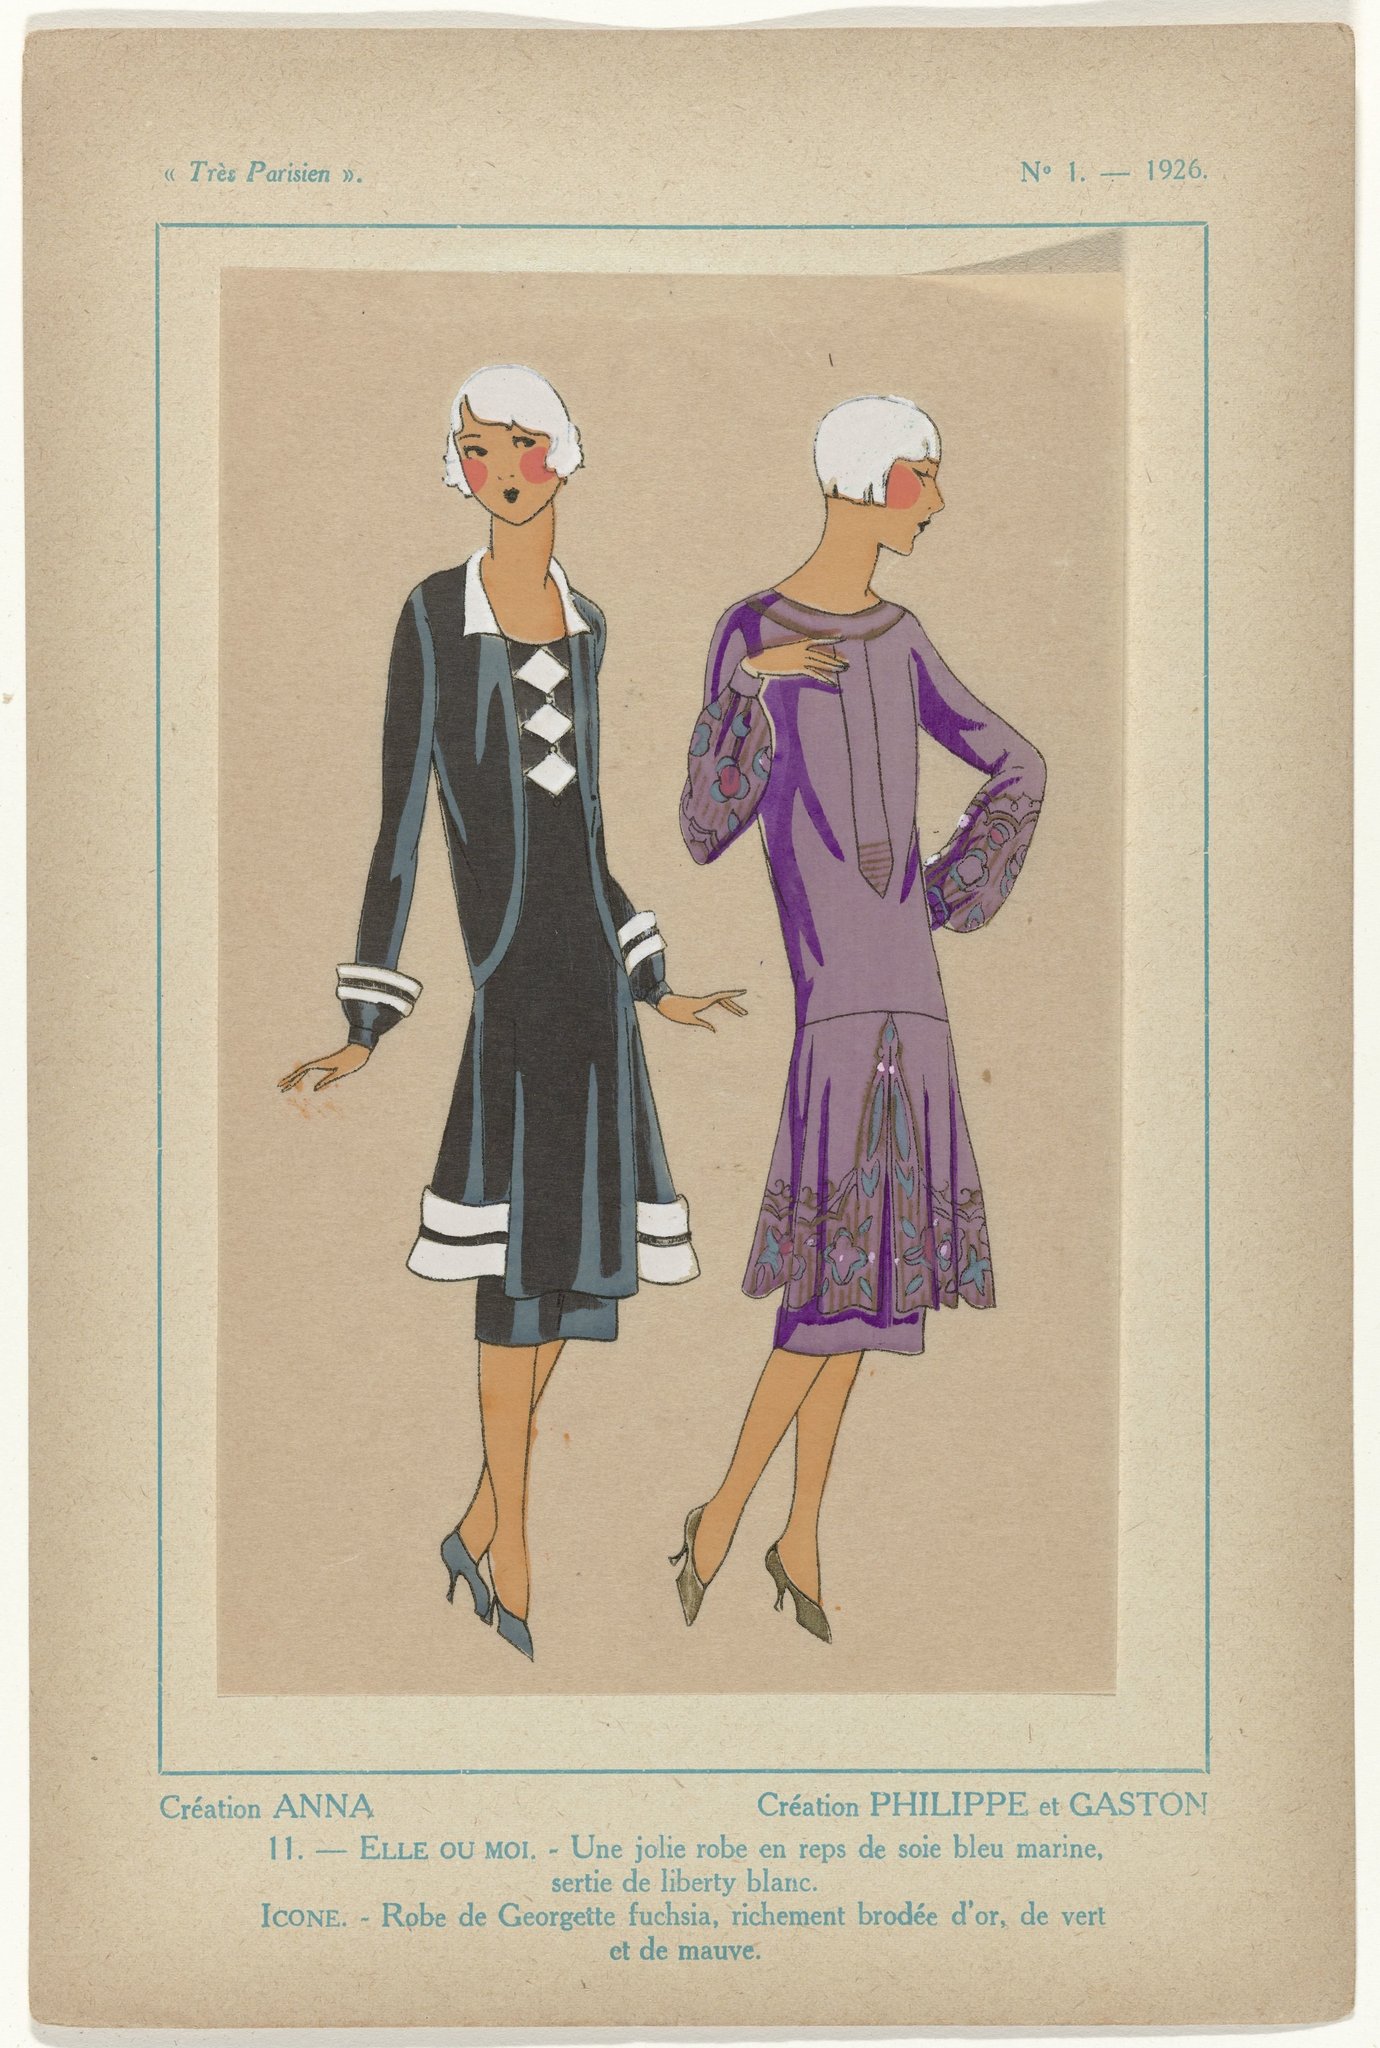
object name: fashion print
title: Très Parisien, 1926, No. 1, Pl. 11: Création ANNA, Création PHILIPPE ET GASTON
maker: g-p. joumard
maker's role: publisher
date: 1926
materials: paper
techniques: hand coloring, letterpress printing, lithography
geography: paris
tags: dress, gown: day dress (+ women's clothes), fashion plates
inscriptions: caption: ‘ELLE OU MOI:une jolie robe de reps en soie bleu marine, sertie de liberty blanc. ICONE.- Robe de Georgette fuchsia, richement brodée d'or, de vert et de mauve.’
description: Japonnen van Anna en Philippe et Gaston: ELLE OU MOI: marineblauwe japon, afgezet met wit; ICONE: japon van georgette in de kleur fuchsia, geborduurd in goud, groen en mauve. PPrent uit het modetijdschrift Très Parisien...La Mode, Le Chic, L'Élégance (1920-1936)